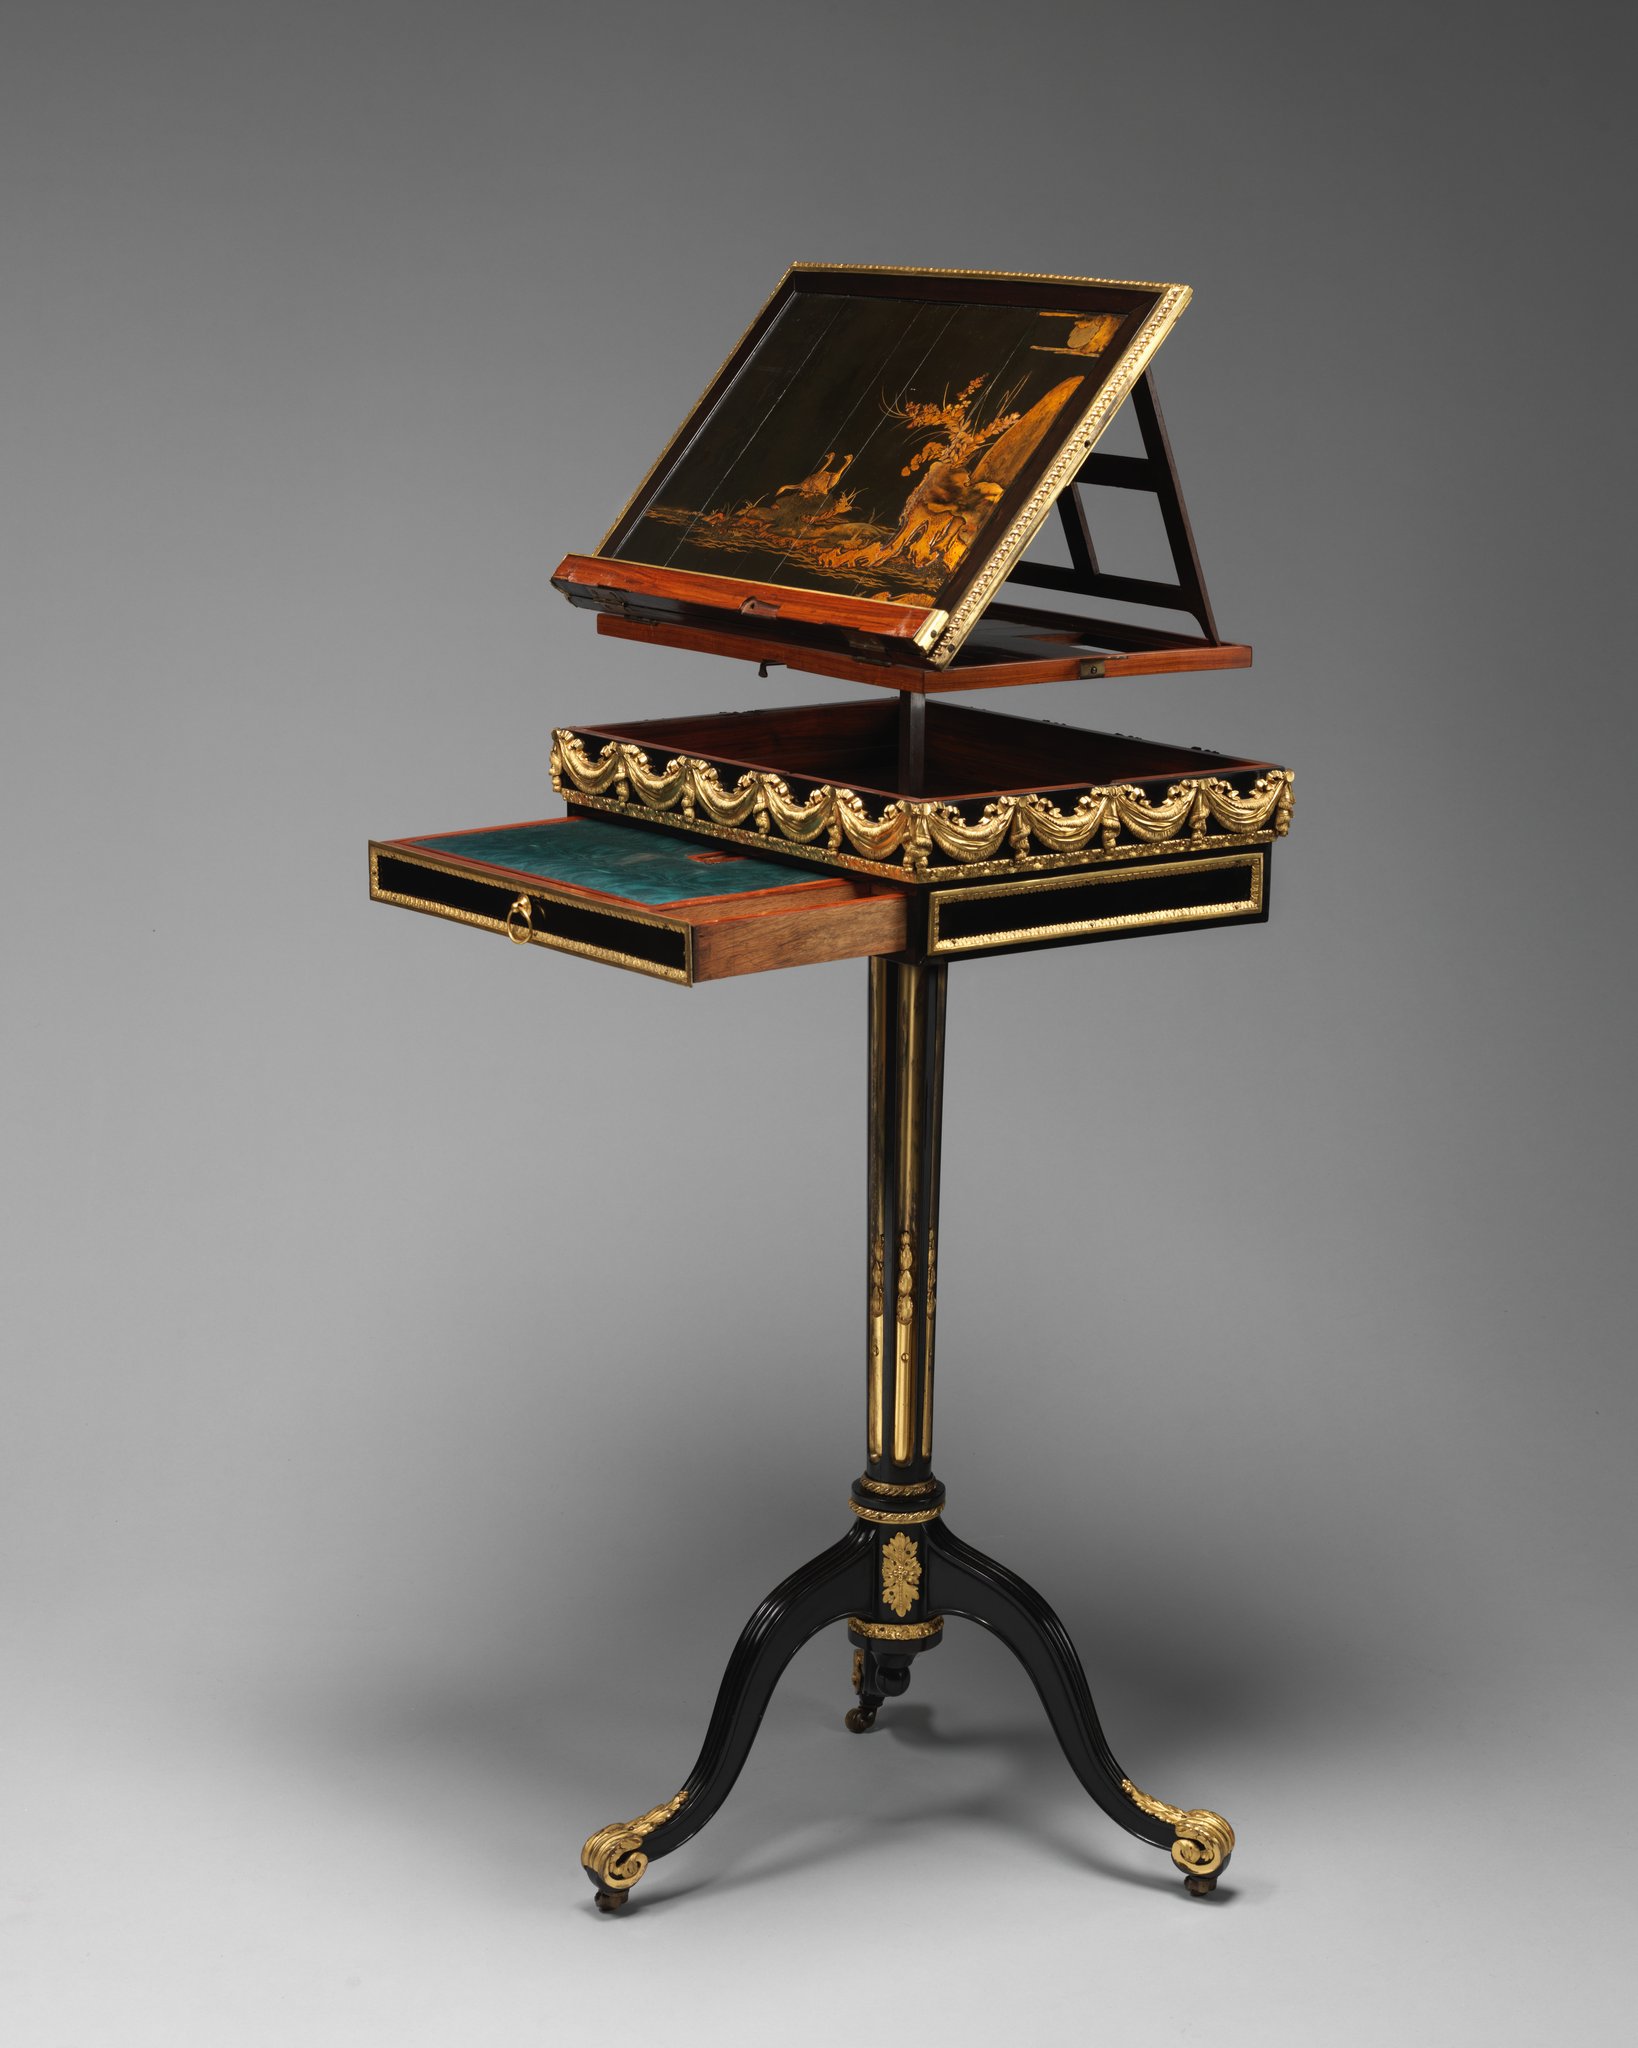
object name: combined work, writing, and reading table and music stand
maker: martin carlin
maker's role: maker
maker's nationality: french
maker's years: 1725-1785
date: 1775-1780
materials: bronze, wood, gold, lacquer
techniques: chasing, gilding, veneering